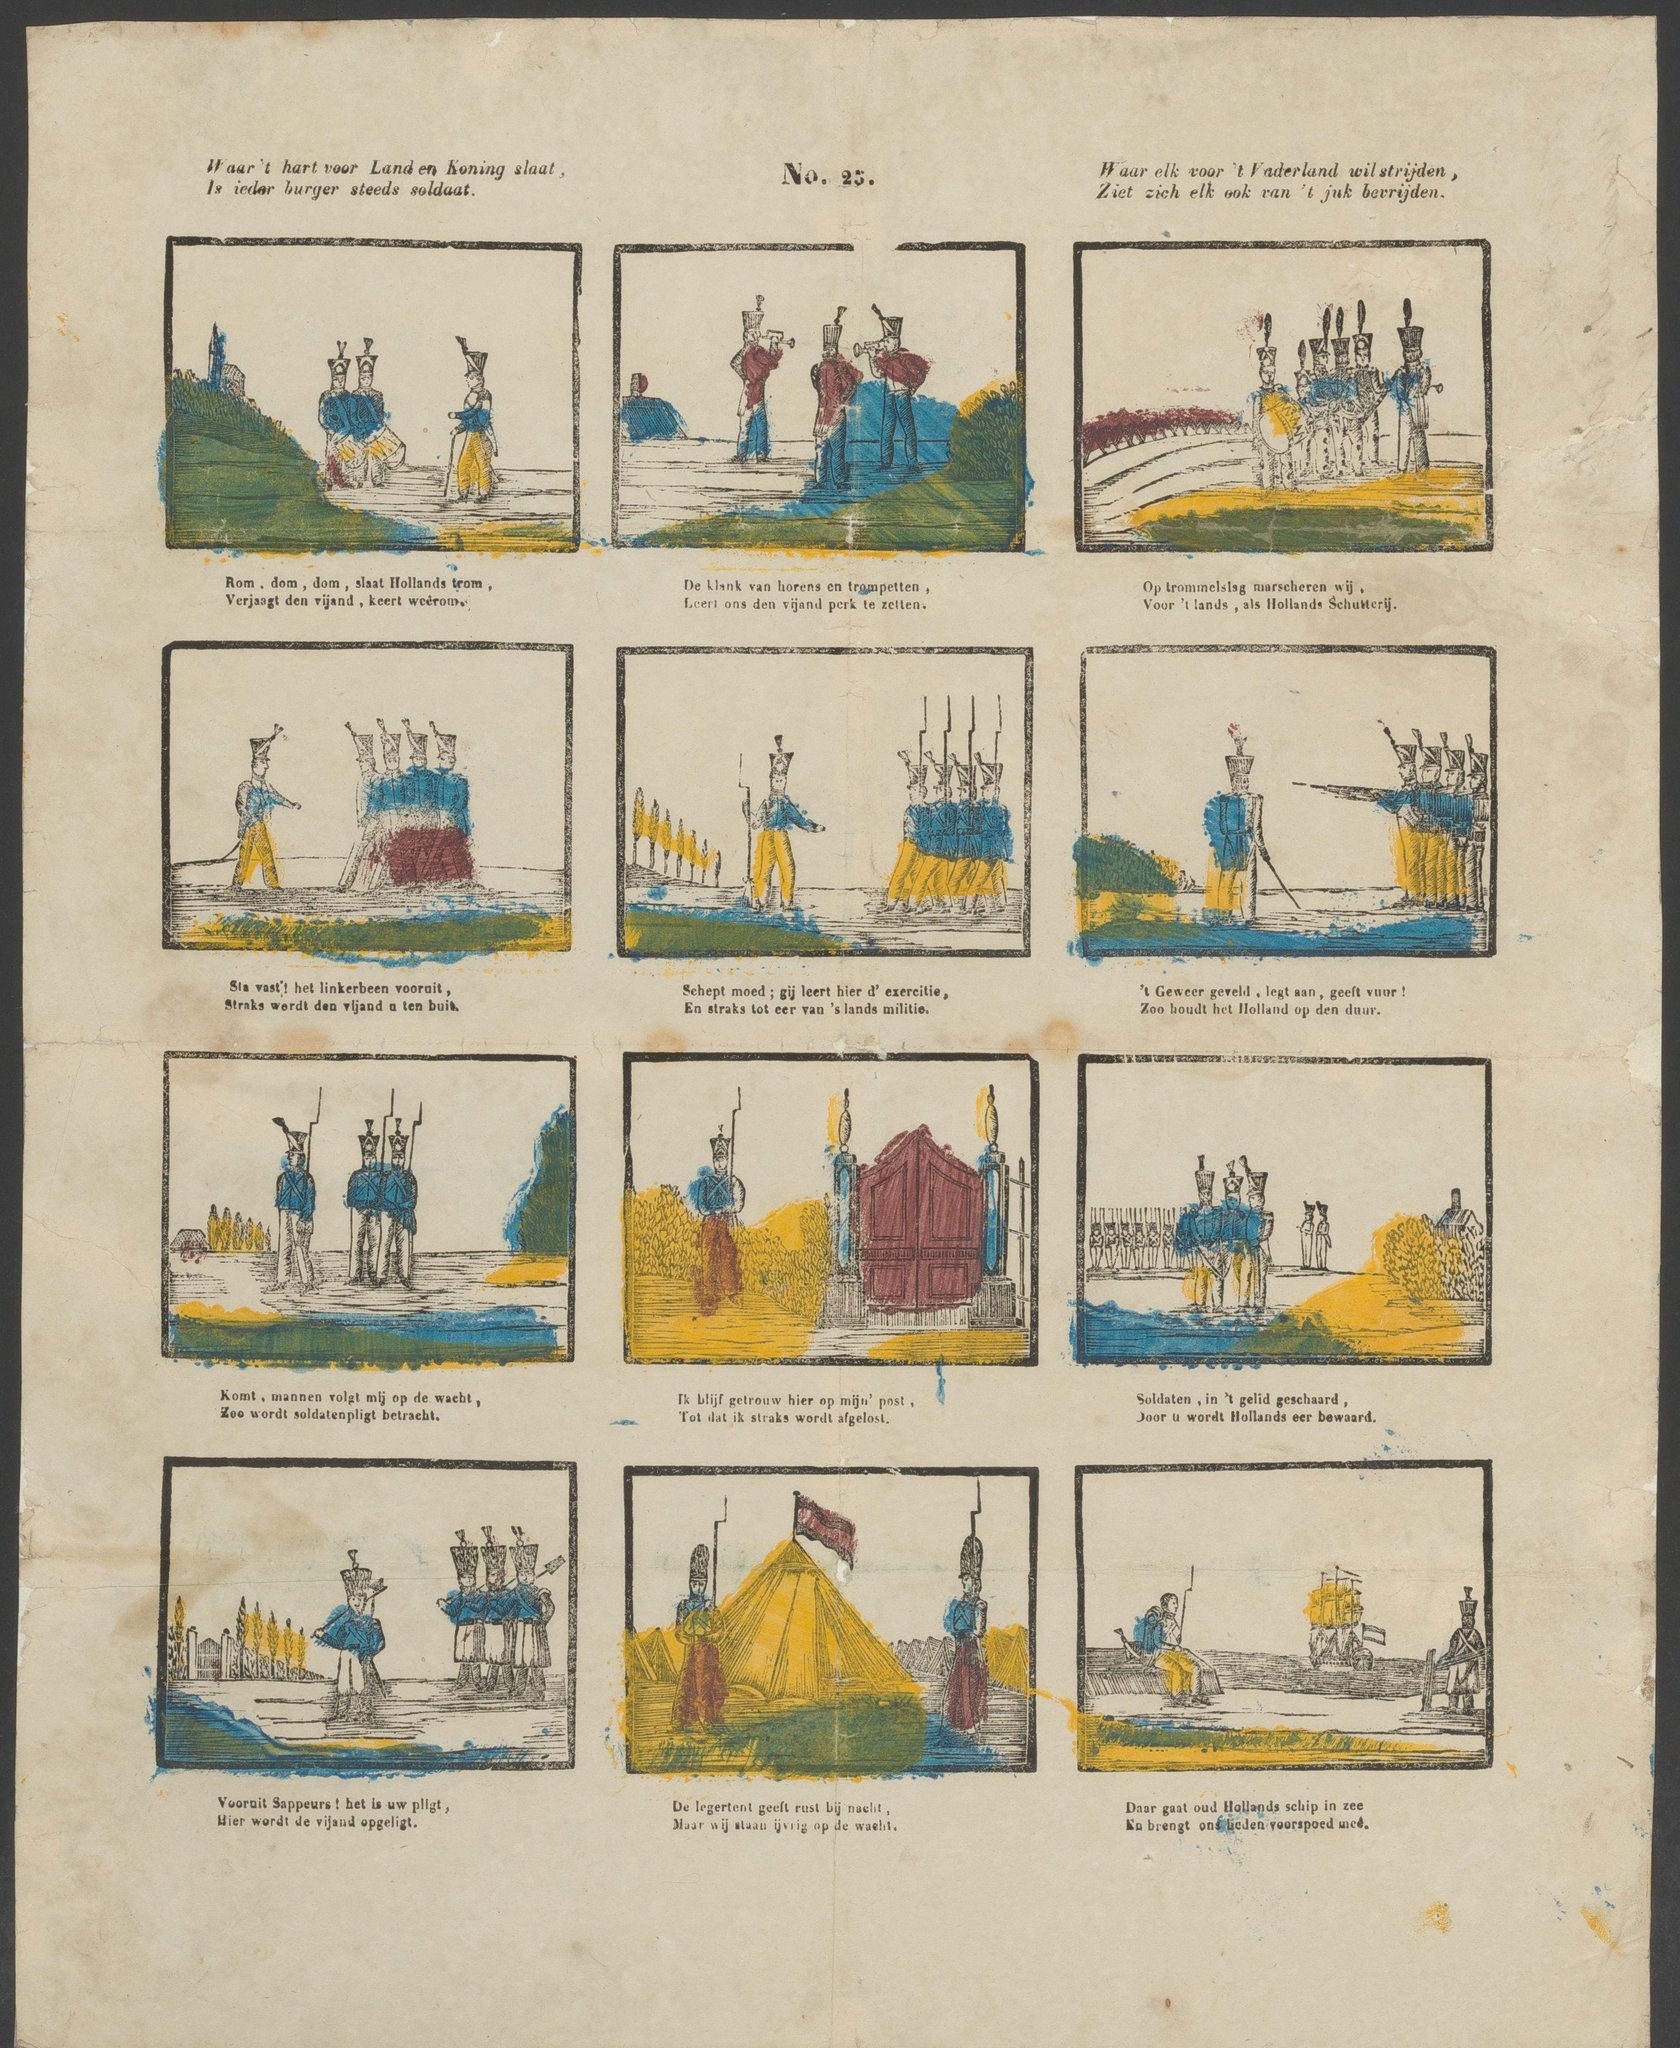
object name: popular print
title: Waar 't hart voor land en koning slaat / Is ieder burger steeds soldaat (...)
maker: Anonymous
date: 1848-1881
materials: paper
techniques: hand coloring, letterpress printing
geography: den bosch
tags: the soldier; the soldier's life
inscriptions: stamp, collector's mark: Lugt 1641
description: Blad met twaalf voorstellingen van militairen. Onder elke afbeelding een tweeregelig vers. Bovenaan genummerd: No. 25. Onderwerpsrubrieken binnen de Atlas Zeden en Gewoonten: Zeden en Gewoonten in Engeren Zin, Des menschen beging, midden en einde, Kinderleven – Kinderspel en Kinderprenten.